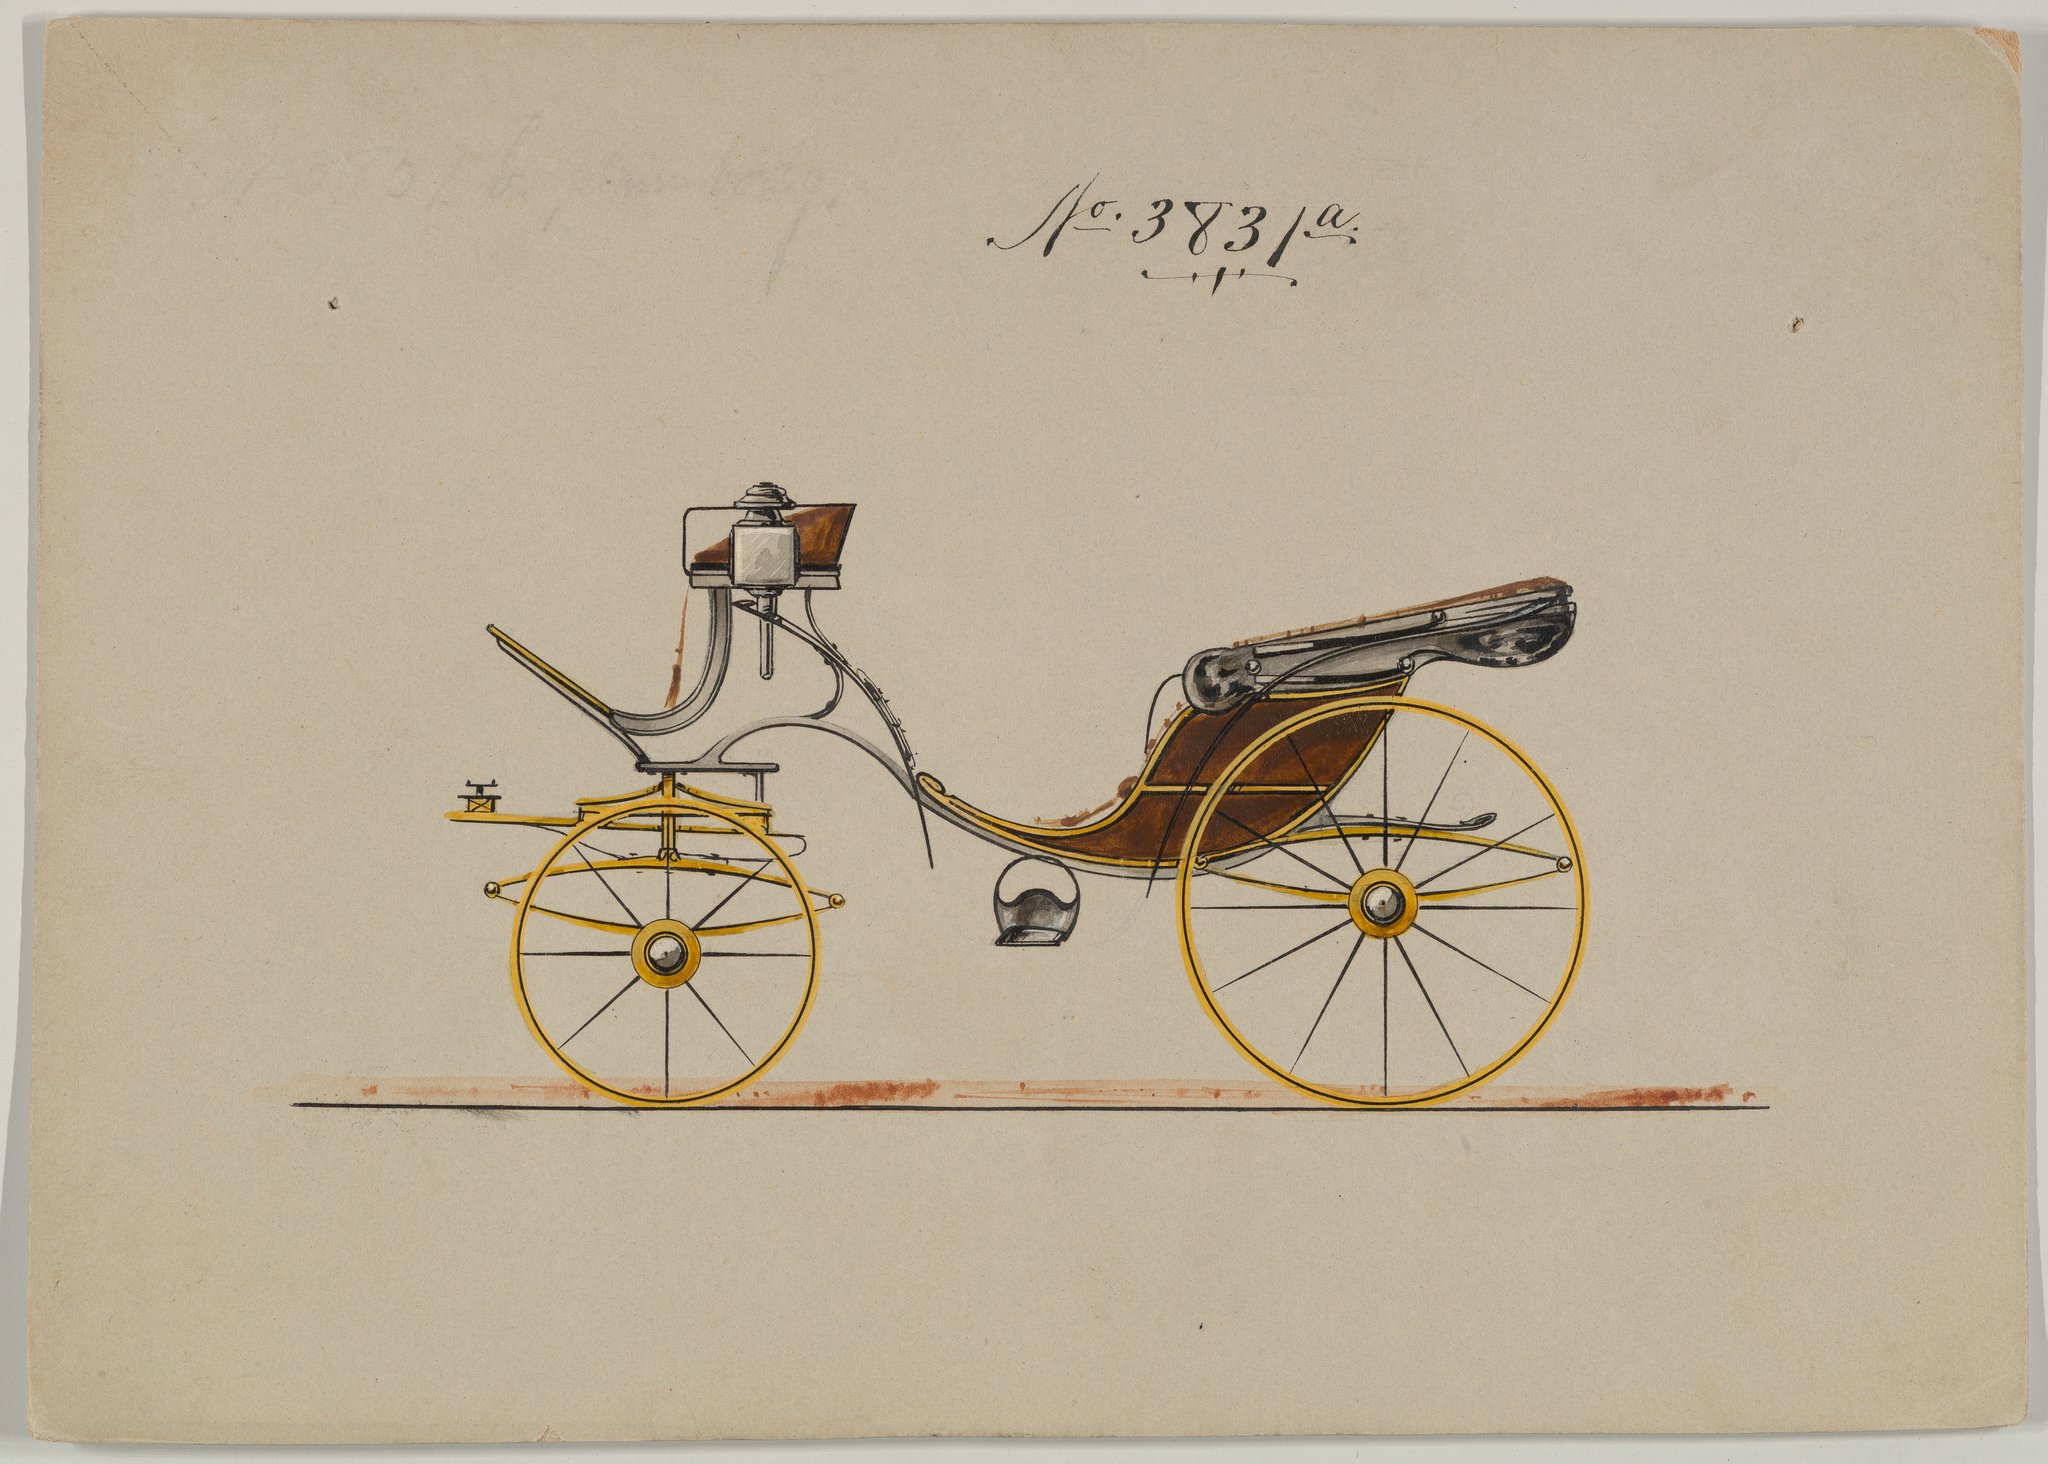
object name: drawing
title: Design for Cabriolet or Victoria, no. 3831a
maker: brewster & co.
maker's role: manufacturer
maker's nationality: american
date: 1883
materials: gouache, ink, watercolor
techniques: pen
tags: carriages